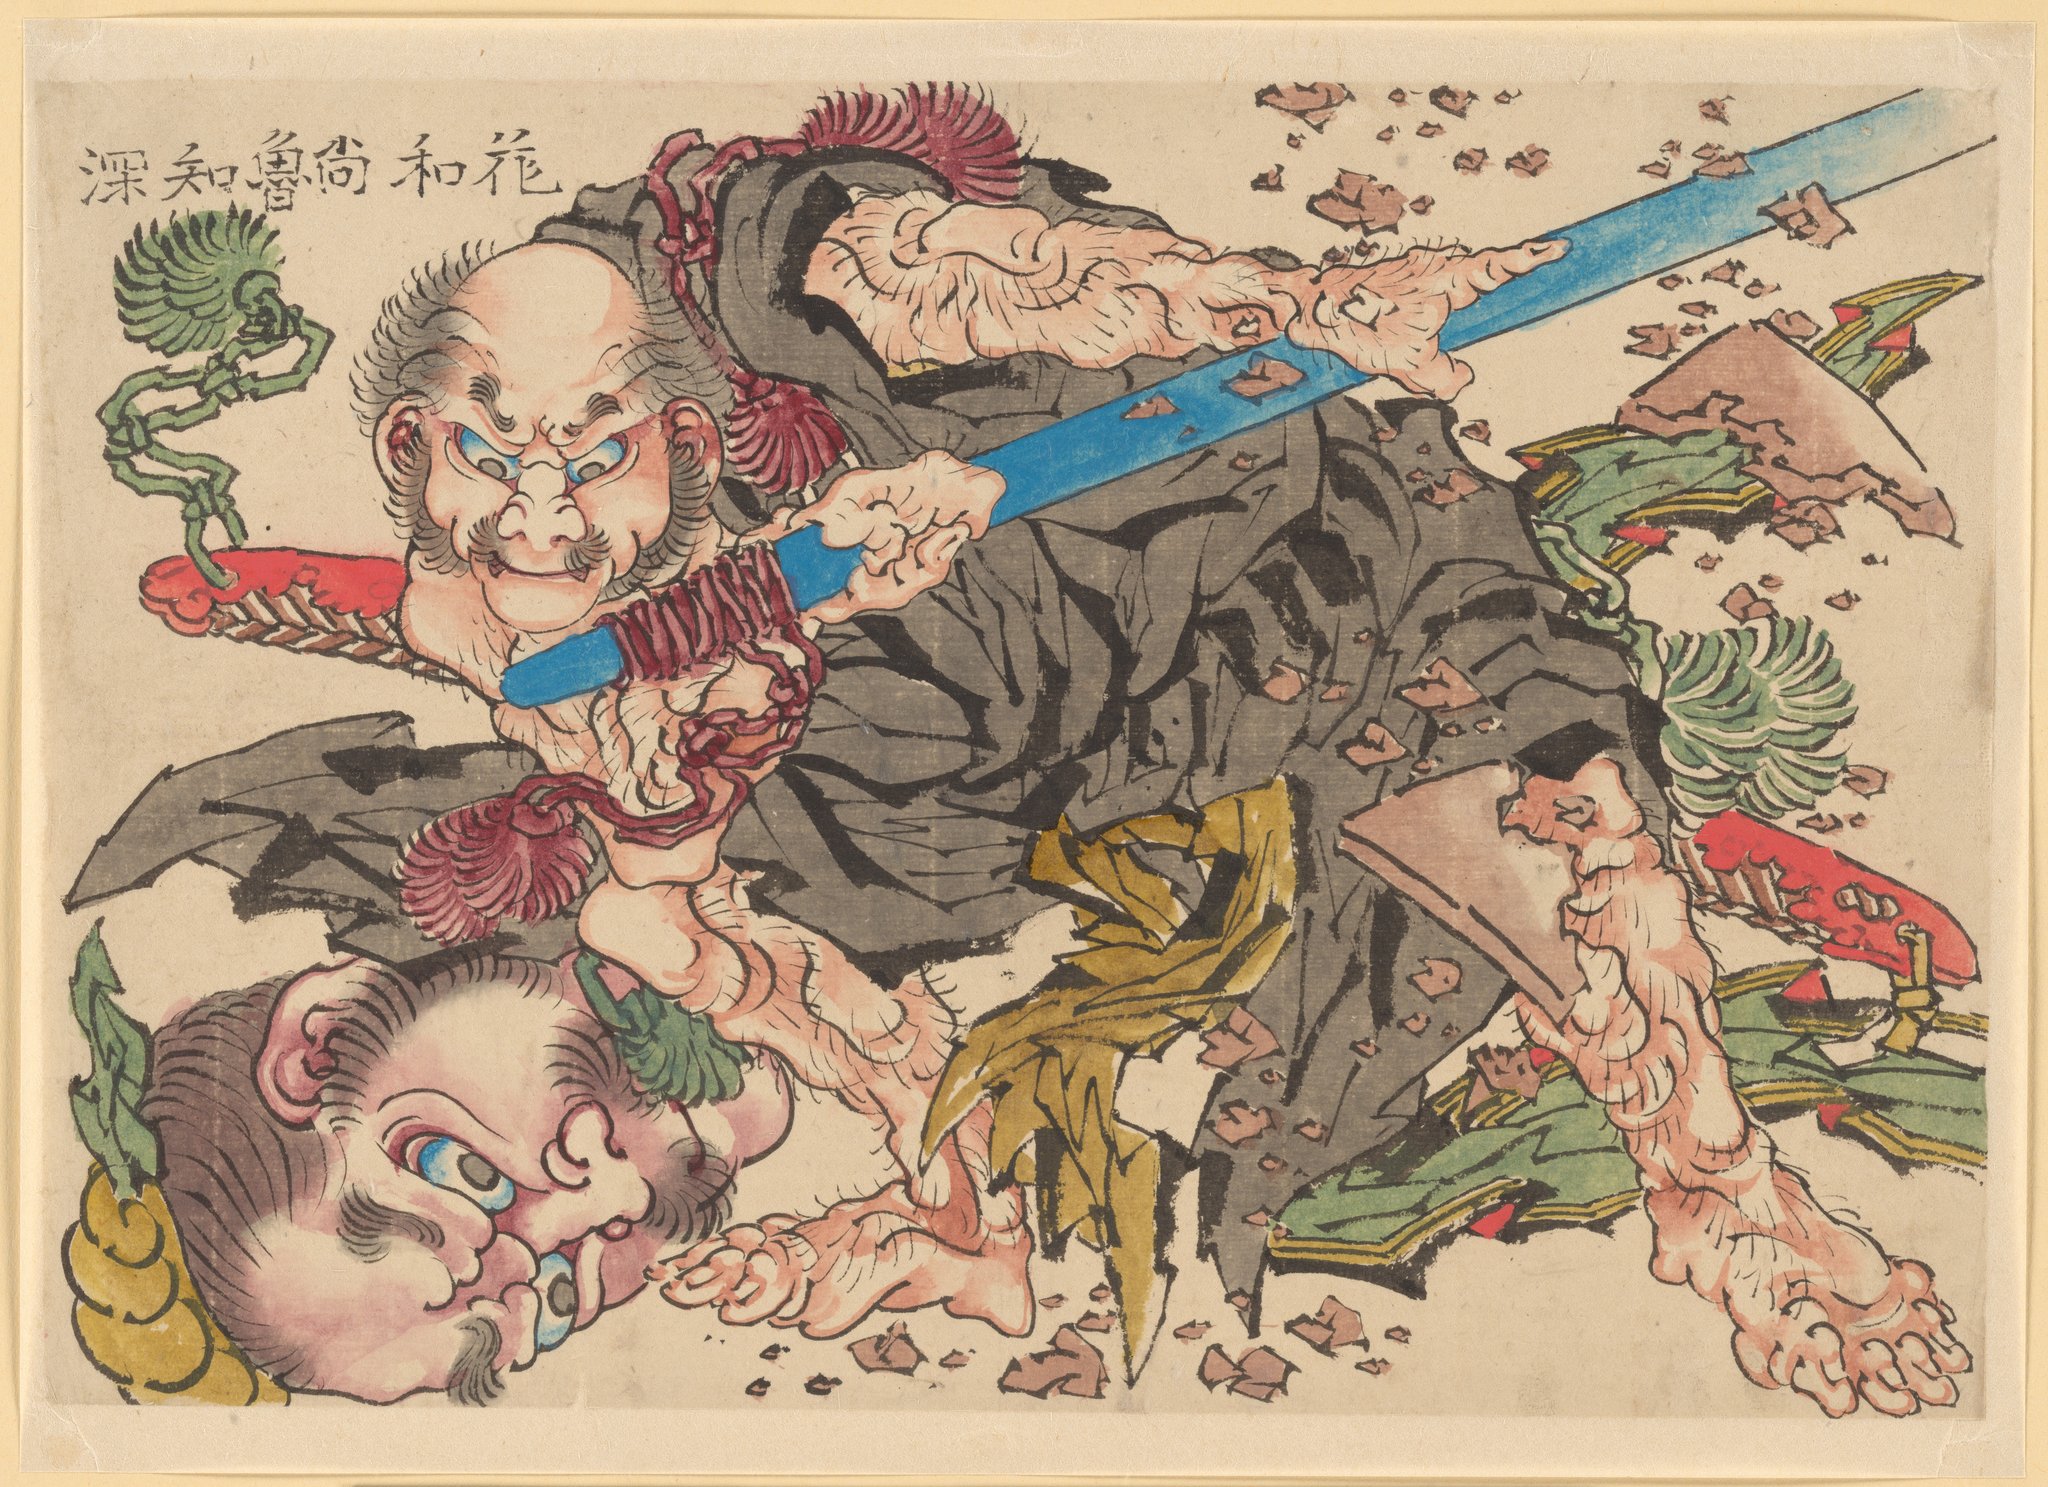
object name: painting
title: Rochishin Chopping Off the Head of Nio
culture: japanese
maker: katsushika hokusai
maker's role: artist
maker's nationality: japanese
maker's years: 1760-1849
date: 1701-1900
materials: ink, paper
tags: swords,men